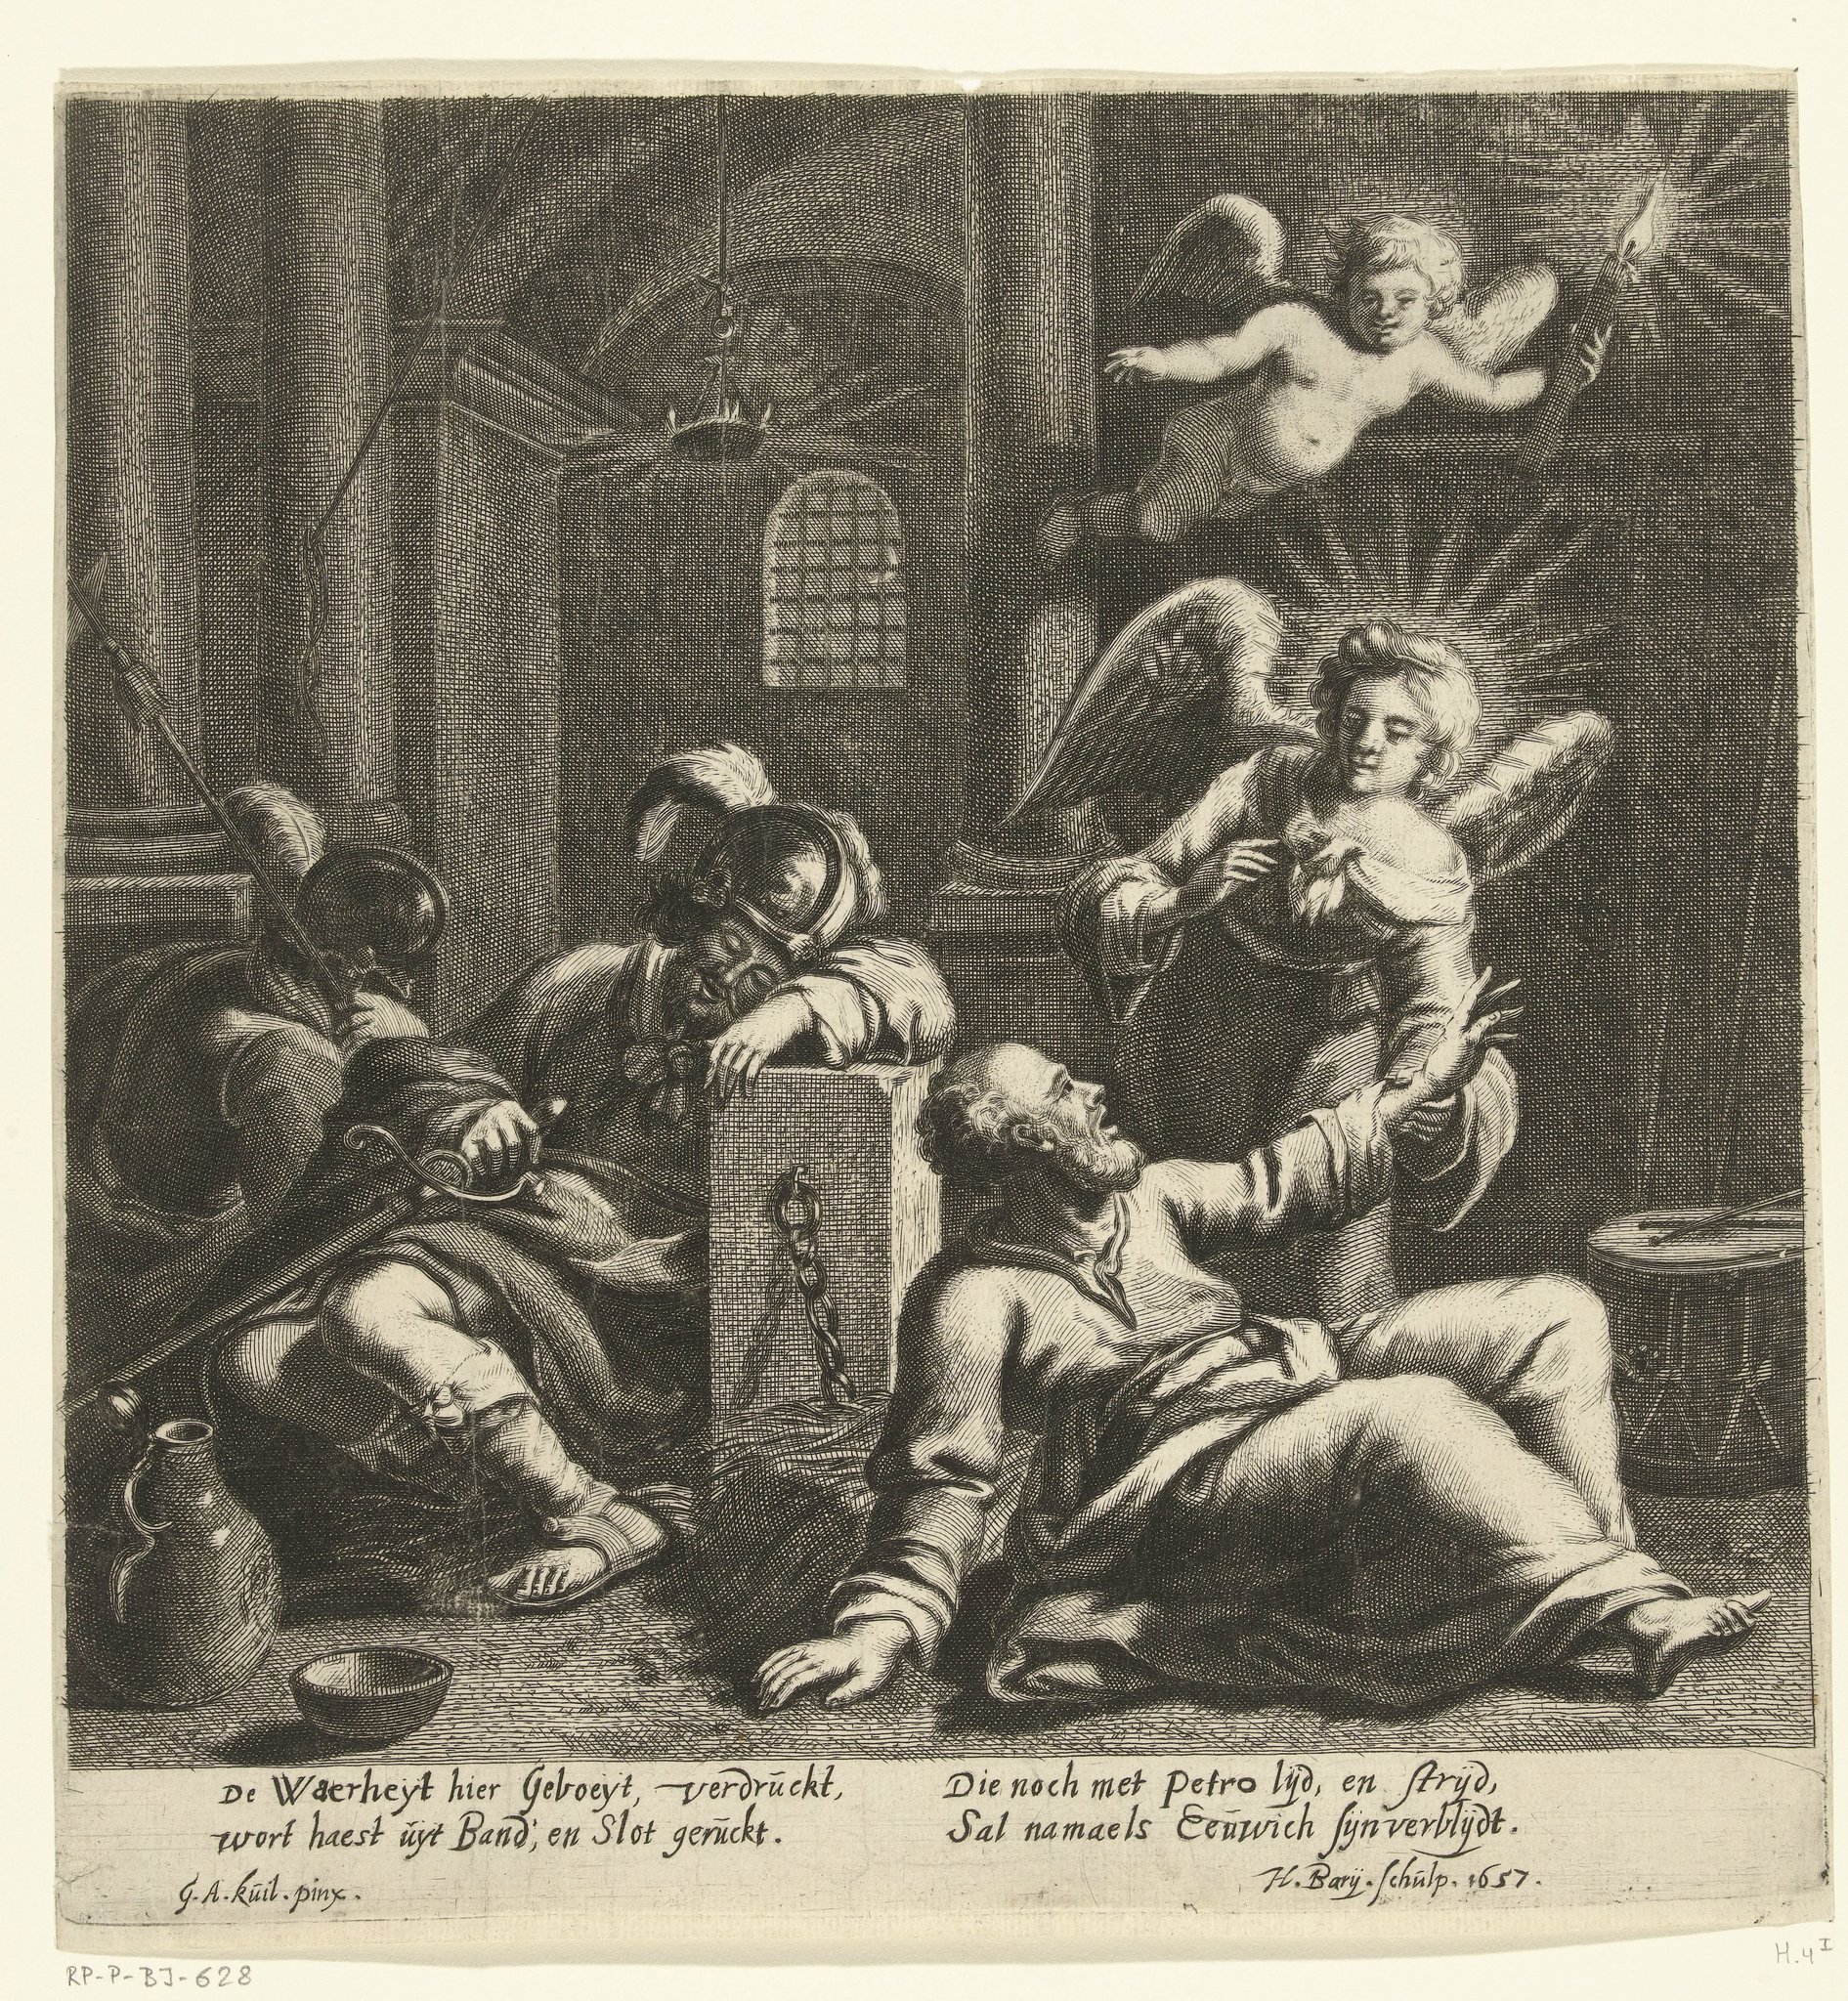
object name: print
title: Petrus wordt uit de gevangenis bevrijd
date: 1657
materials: paper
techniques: engraving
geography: netherlands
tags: prison, jail, an angel appears, summoning peter to wake up ~ peter in prison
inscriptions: collector's mark: Lugt 240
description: Petrus ligt in de gevangenis, de bewakers slapen. Een engel maakt Petrus wakker. Een engeltje houdt een brandende kaars vast. Onder de voorstelling een vers in twee kolommen van elk twee regels in het Nederlands.